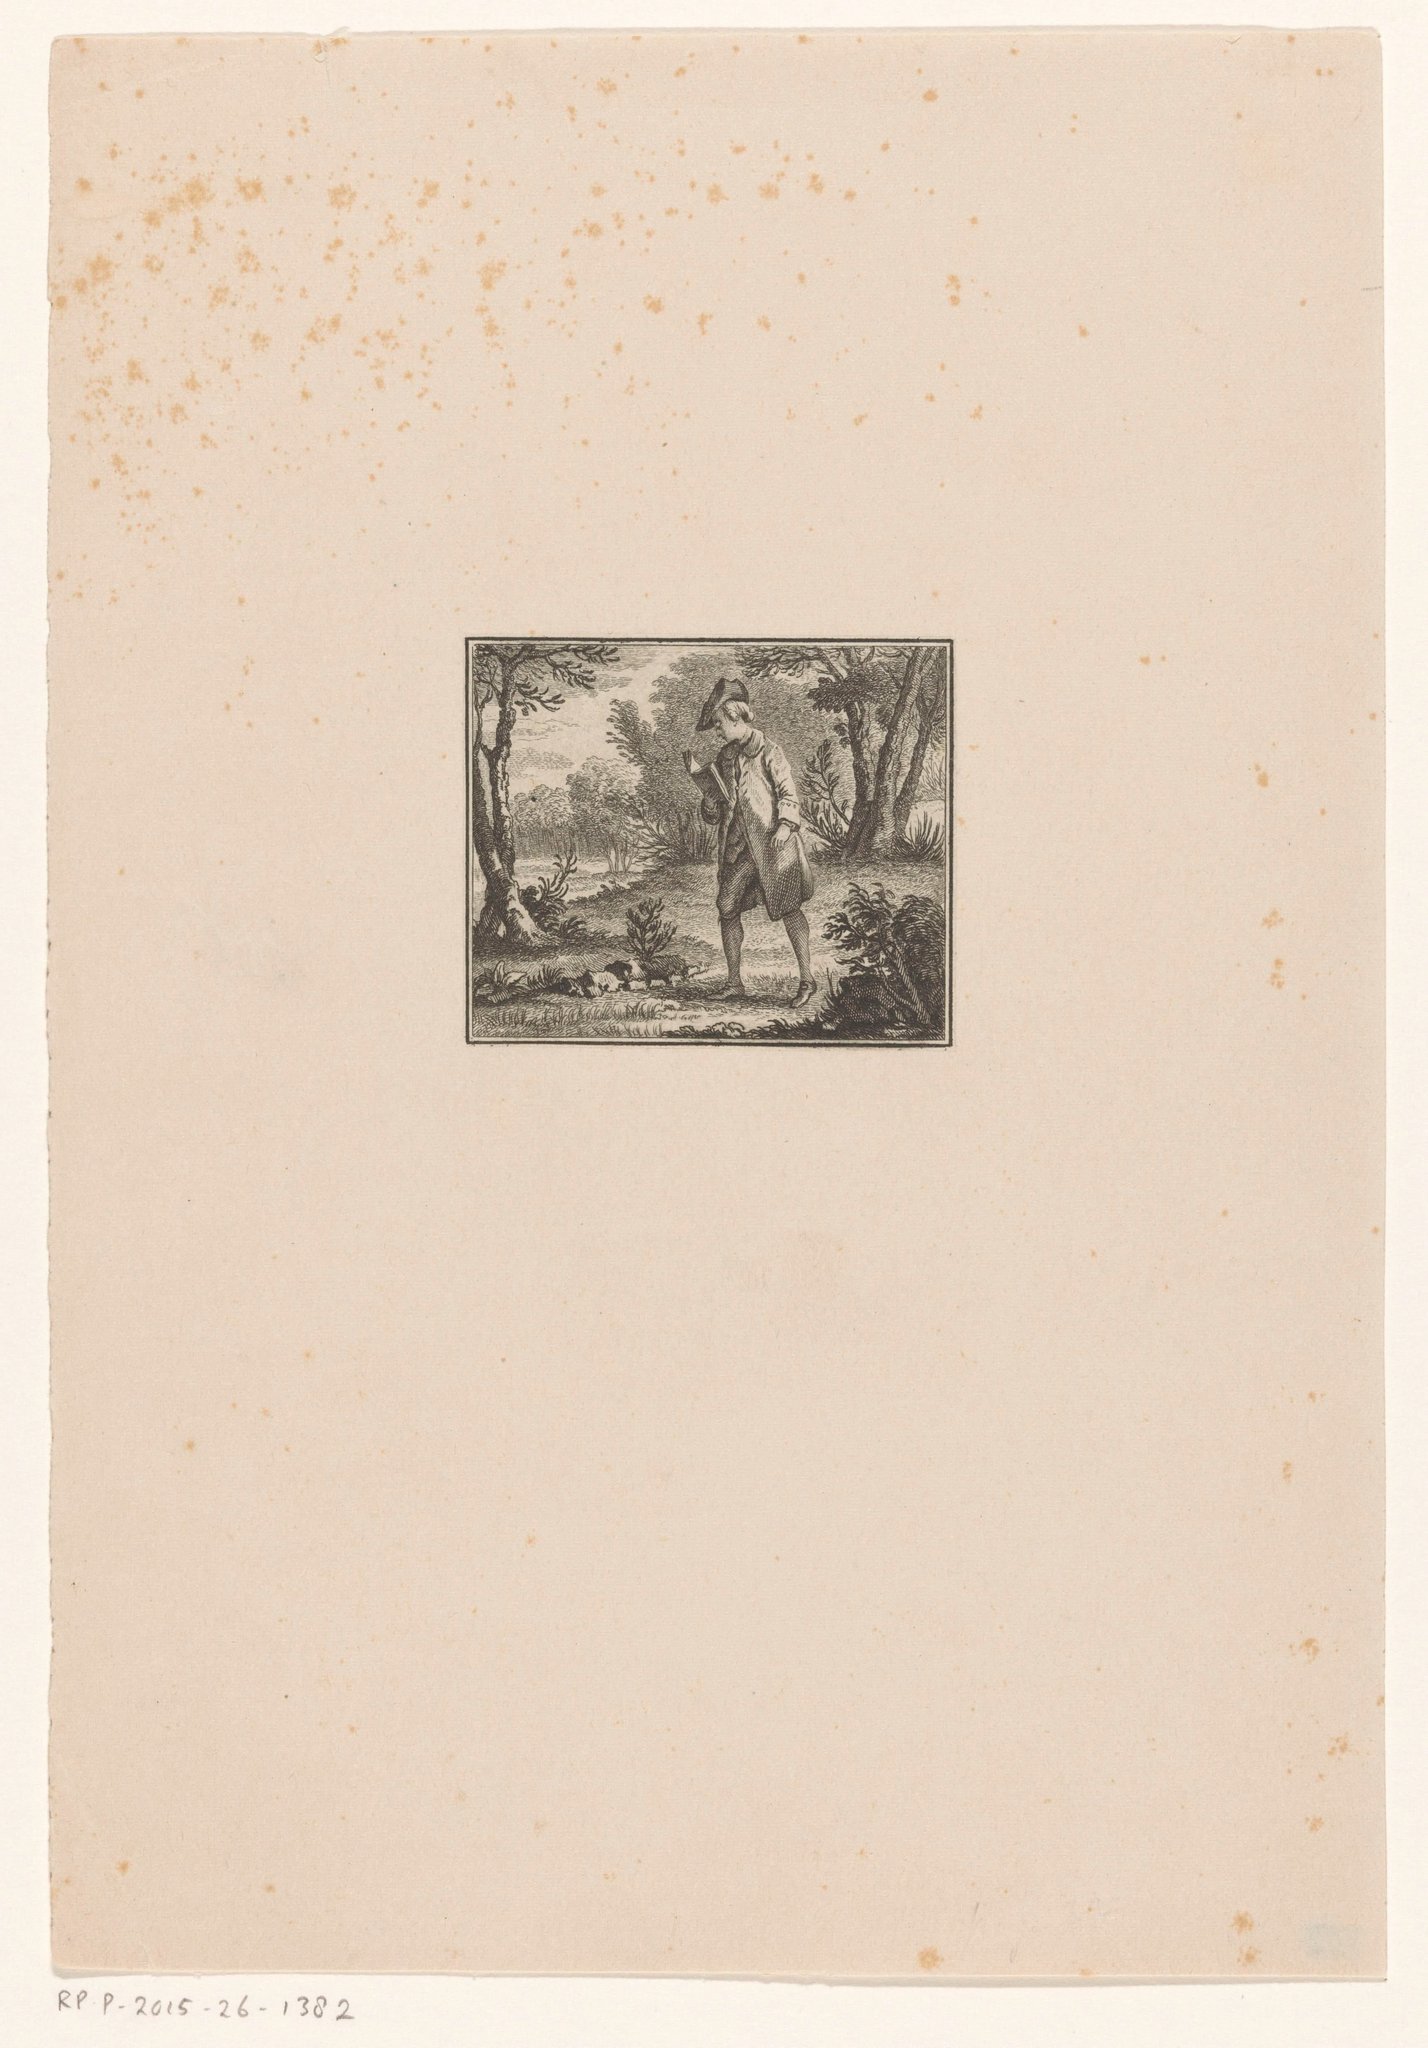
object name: print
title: Lezende man in het bos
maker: balthasar anton dunker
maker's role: draughtsman, print maker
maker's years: 1746-1807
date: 1756-1807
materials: paper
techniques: engraving, etching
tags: reading, book, forest, wood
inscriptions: collector's mark: Lugt 2228, collector's mark: Lugt 4779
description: Een man in achttiende-eeuwse kleding loopt met een boek in zijn rechterhand door het bos.